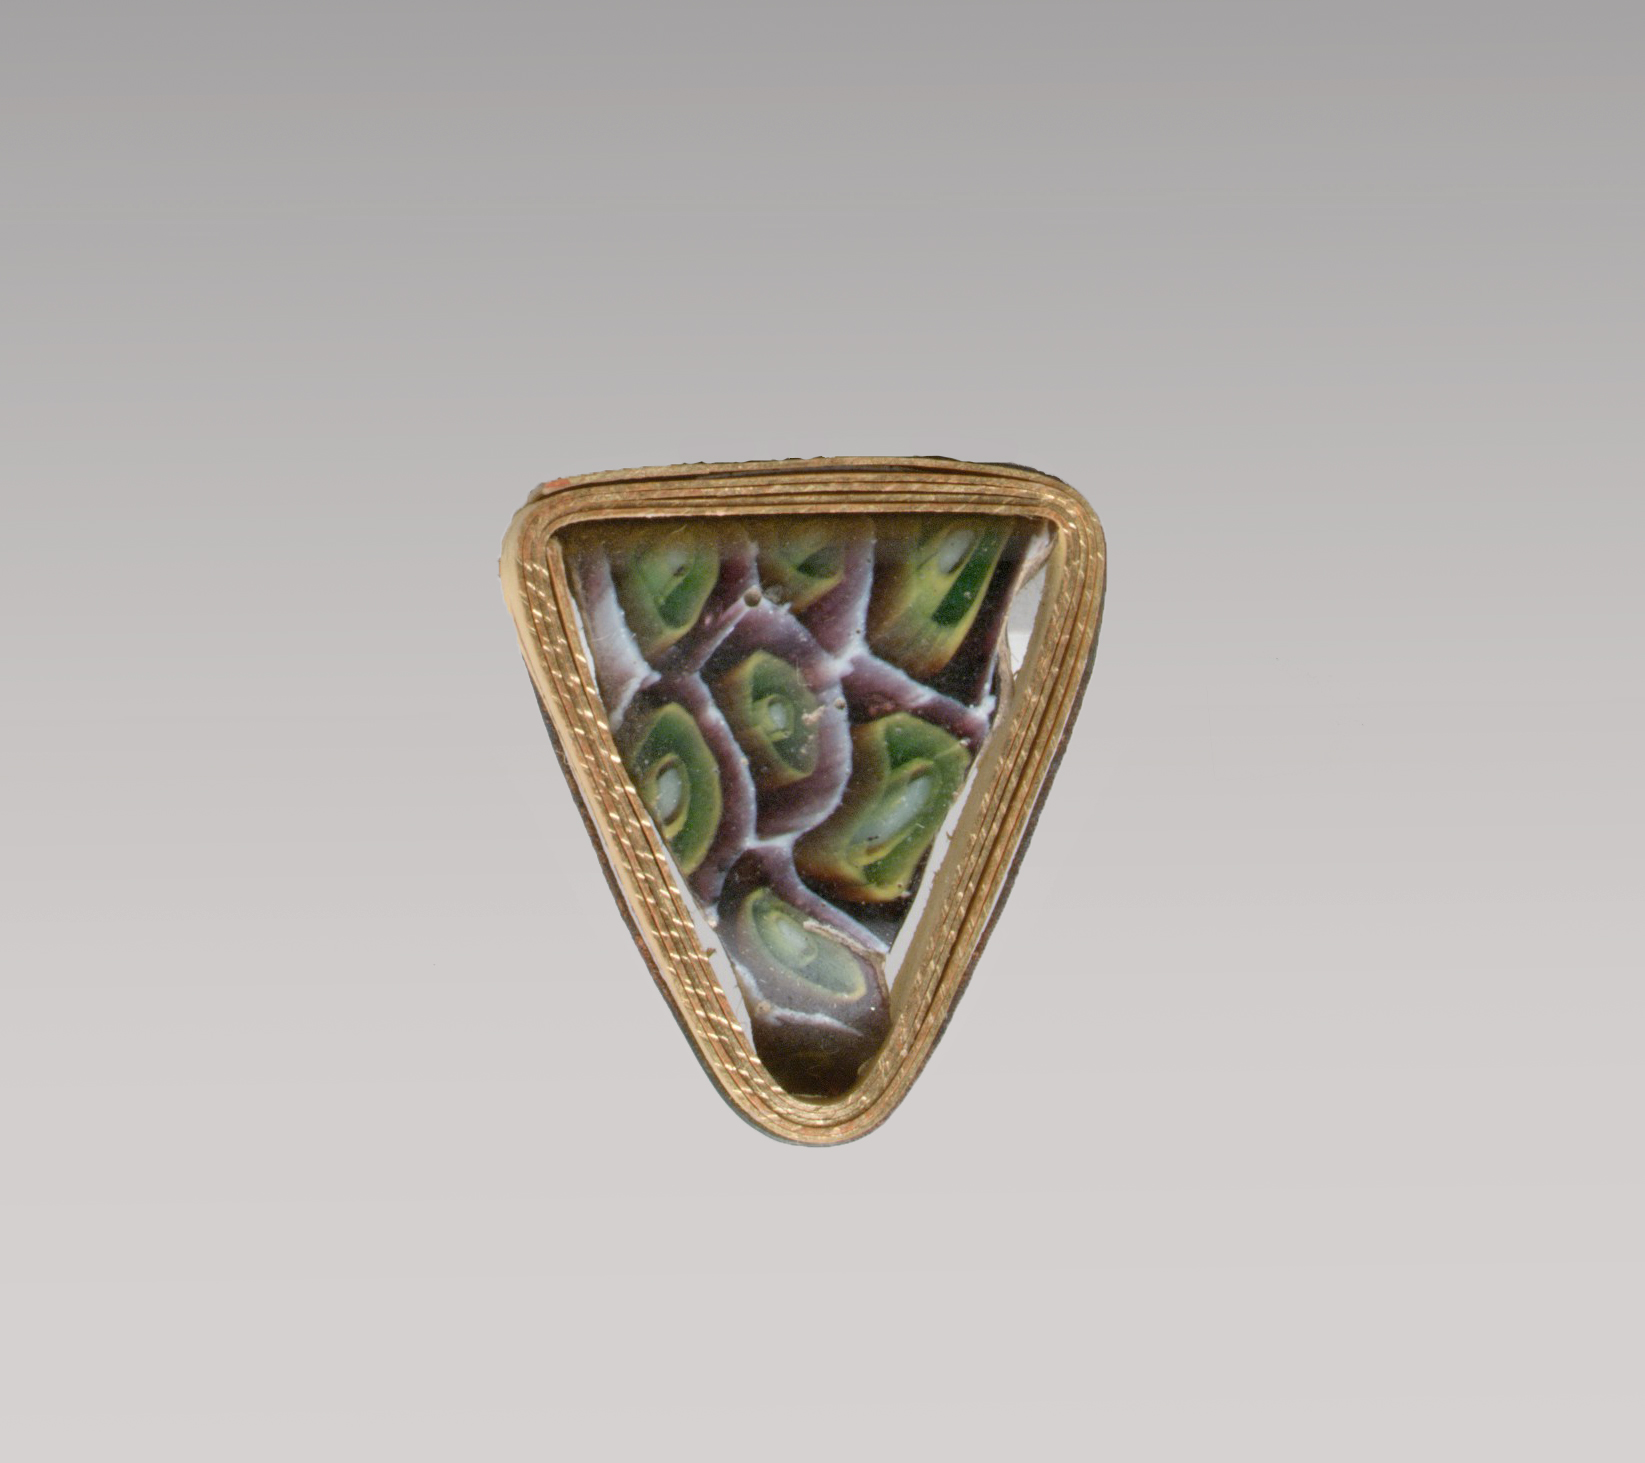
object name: fragment, mosaic bowl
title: Glass mosaic carinated bowl fragment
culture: roman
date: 34 BCE-33 CE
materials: glass